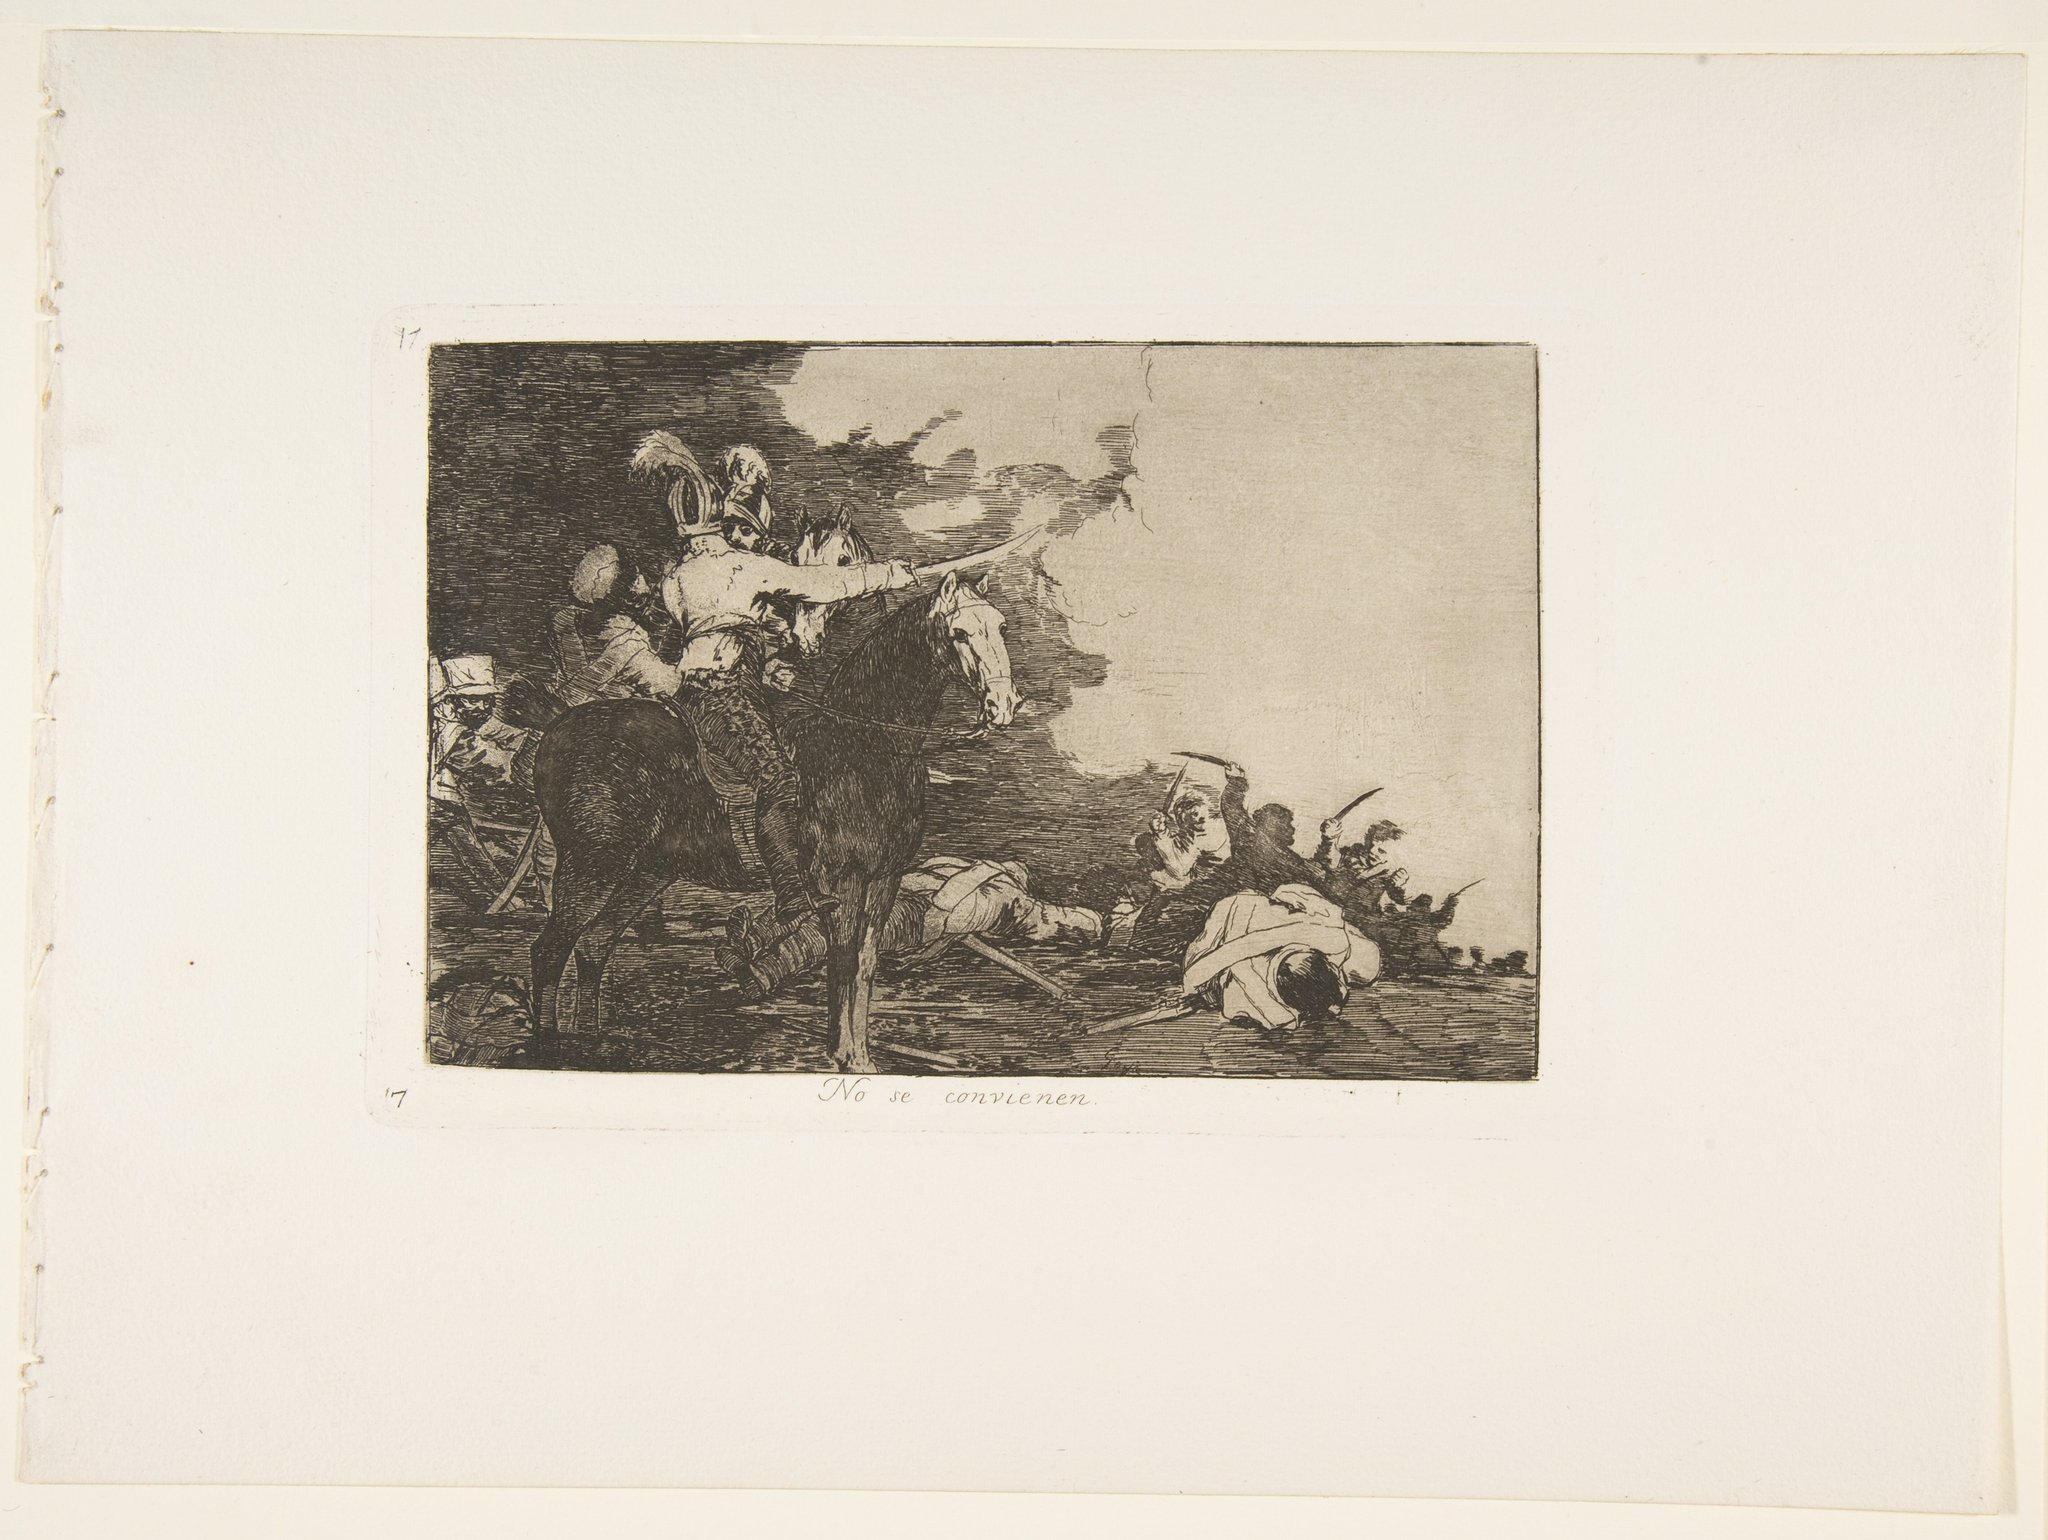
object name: print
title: Plate 17 from "The Disasters of War" (Los Desastres de la Guerra): 'They do not agree' (No se convienen)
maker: goya (francisco de goya y lucientes)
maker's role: artist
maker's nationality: spanish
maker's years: 1746-1828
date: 1810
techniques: engraving, drypoint, etching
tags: swords,men,horses